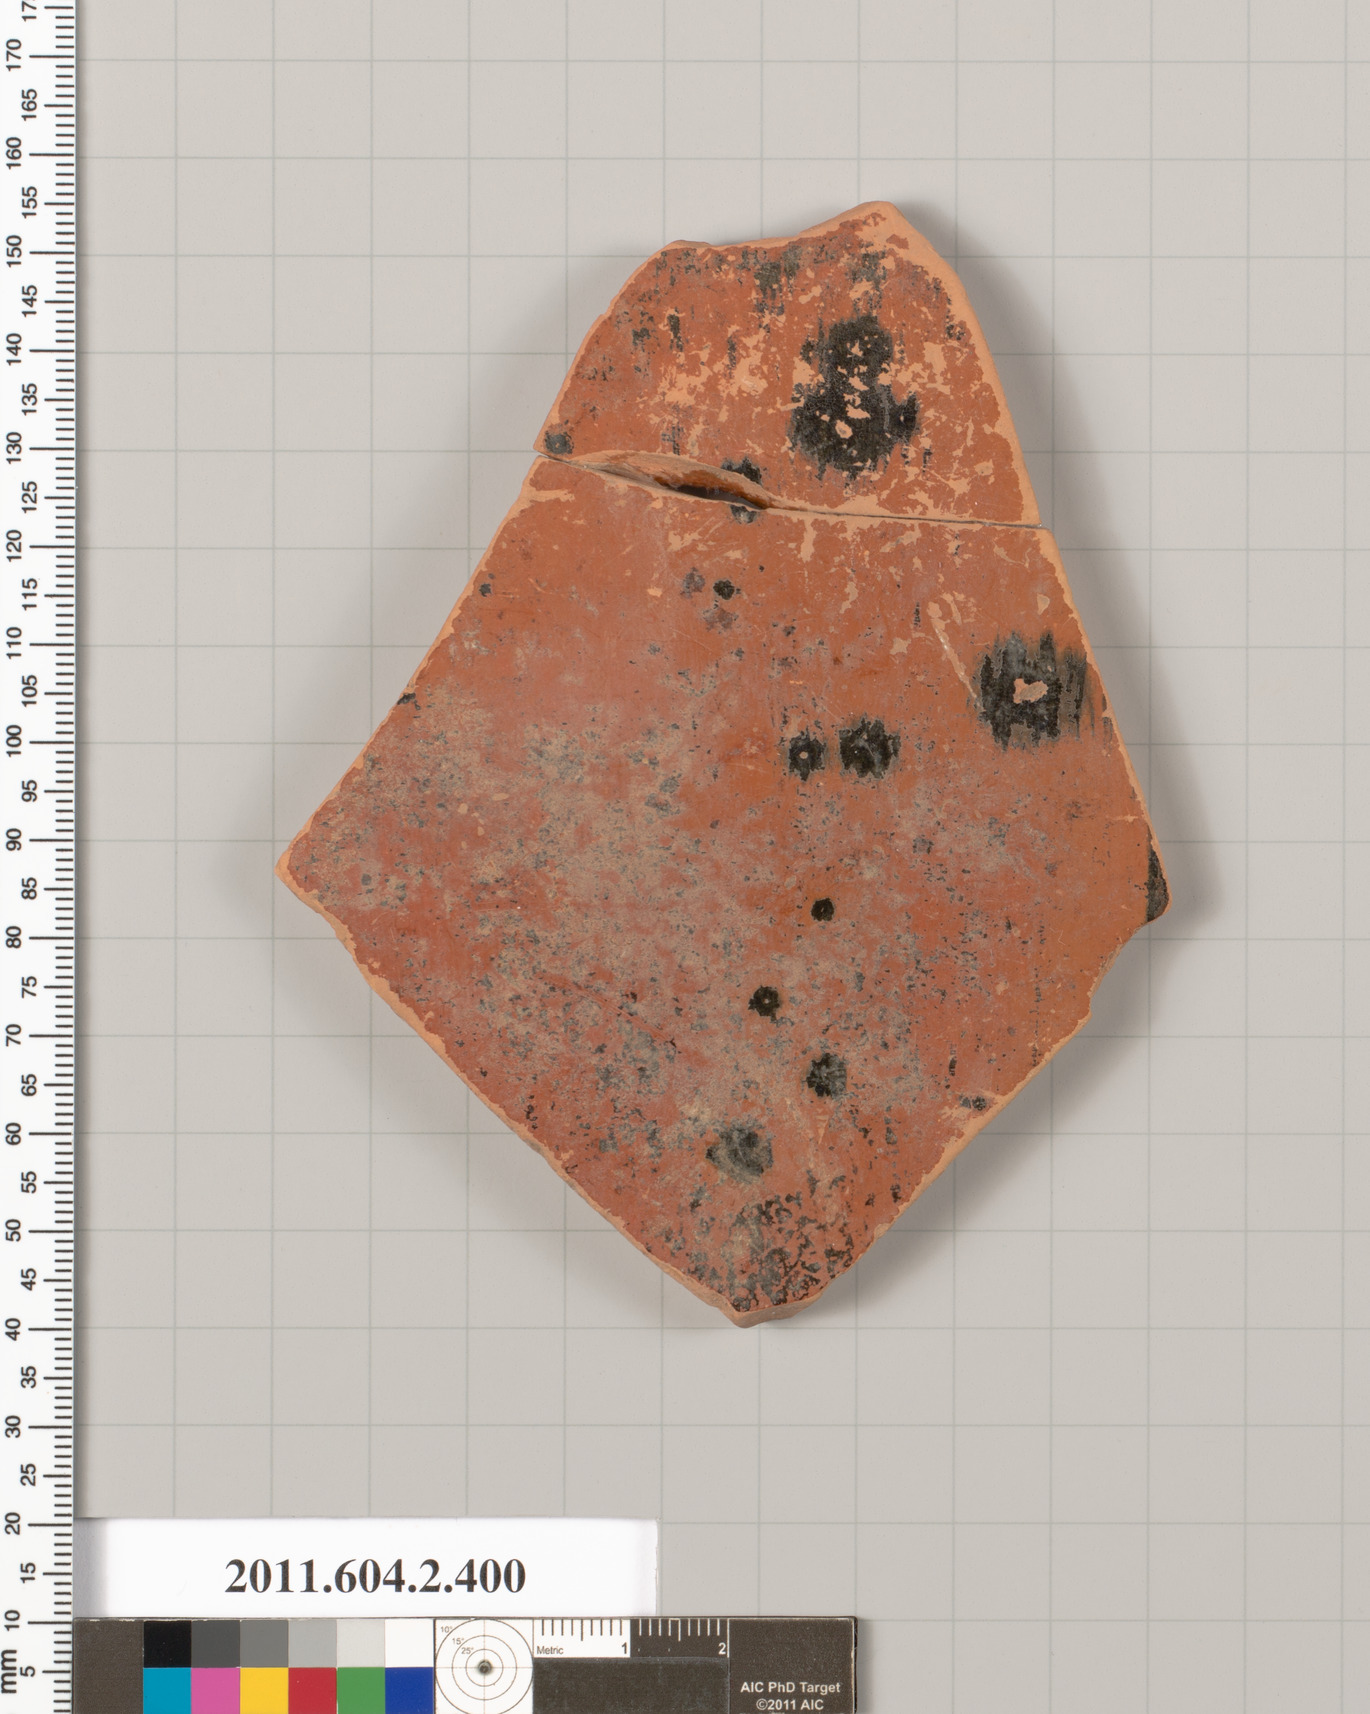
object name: column krater fragment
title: Terracotta fragment of a column-krater (bowl for mixing wine and water)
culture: greek, attic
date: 401-500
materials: terracotta